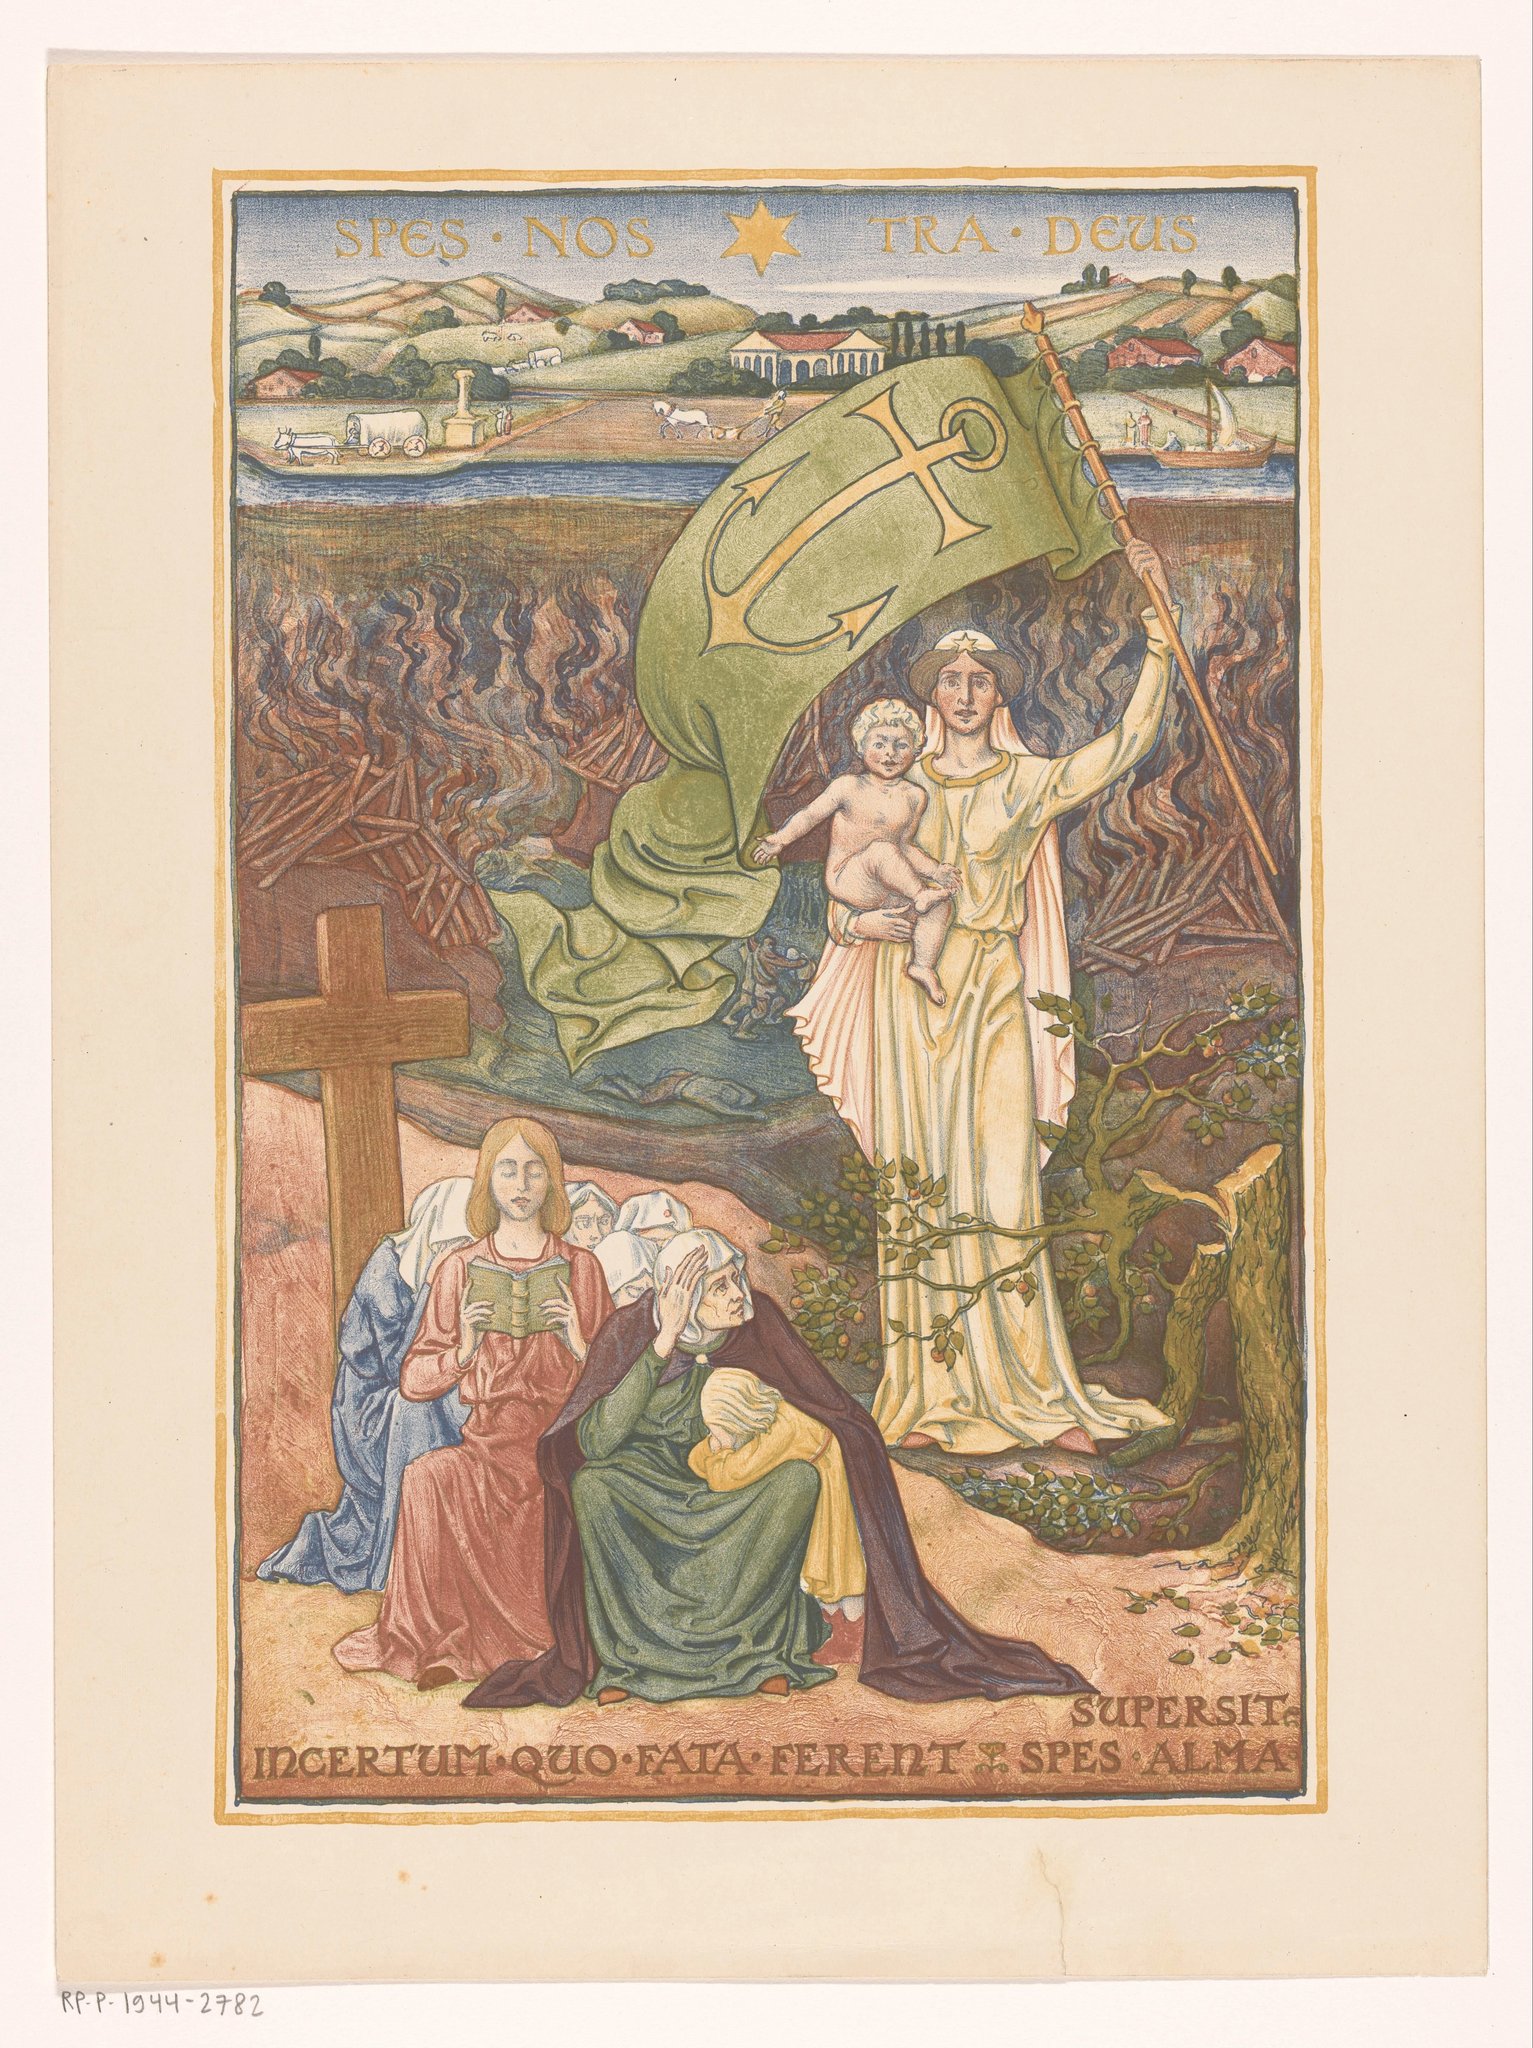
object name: print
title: Transvaalse prent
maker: antoon derkinderen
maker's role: draughtsman, painter, print maker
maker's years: 1859-1925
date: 1902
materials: paper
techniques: lithograph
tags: the cross ~ symbols of christ, hope; 'speranza', 'speranza delle fatiche' (ripa), mother and baby or young child, war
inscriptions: collector's mark: Lugt 2228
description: Een vrouw met een kind in haar armen houdt een vaandel vast waarop een anker, symbool van de hoop, staat. Ze bevindt zich in een verwoest en brandend gebied. Aan haar voeten ligt een afgeknapte boom met vruchten. Links op de voorgrond zit een groep vrouwen gehurkt voor een kruis. Op de achtergrond een Transvaals landschap met landbouwers. Bovenaan het opschrift 'Spes nostra Deus' (God is onze hoop), onderaan het opschrift 'Incertum quo fata ferent spes alma supersit' (onzeker is het waarheen het lot ons voeren zal, moge de hoop blijven).